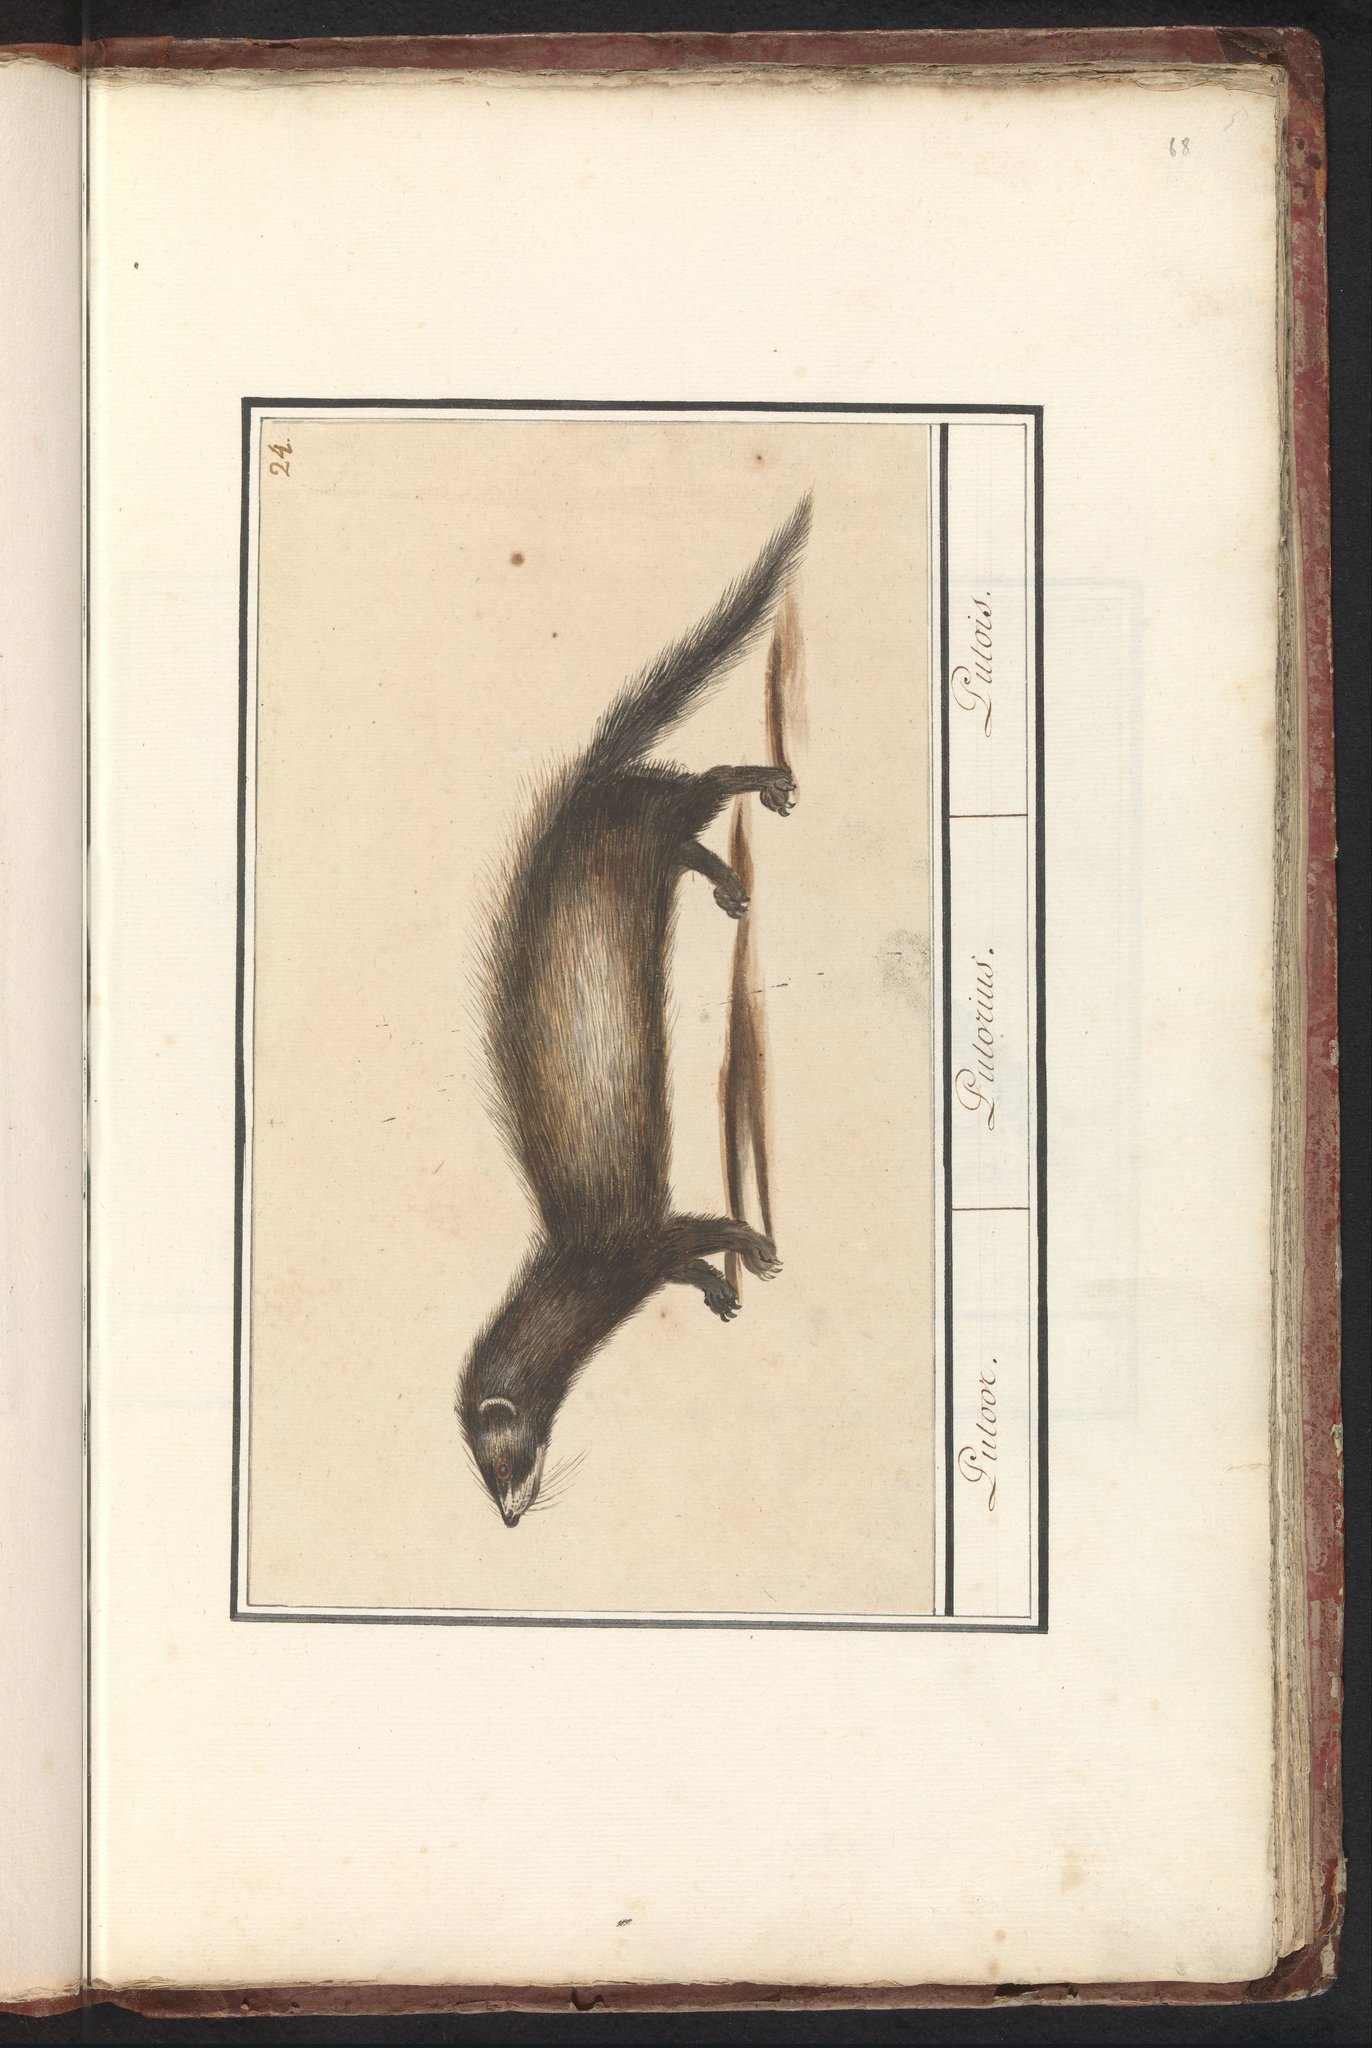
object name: drawing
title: Bunzing (Mustela putorius)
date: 1596-1610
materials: paint, paper, watercolor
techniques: brush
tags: beasts of prey, predatory animals: european polecat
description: Bunzing. Rechtsboven genummerd: 24. Onderdeel van het eerste album met tekeningen van viervoeters. Eerste van twaalf albums met tekeningen van dieren, vogels en planten bekend rond 1600, gemaakt in opdracht van keizer Rudolf II. Met toelichting in Nederlands, Latijn en Frans.